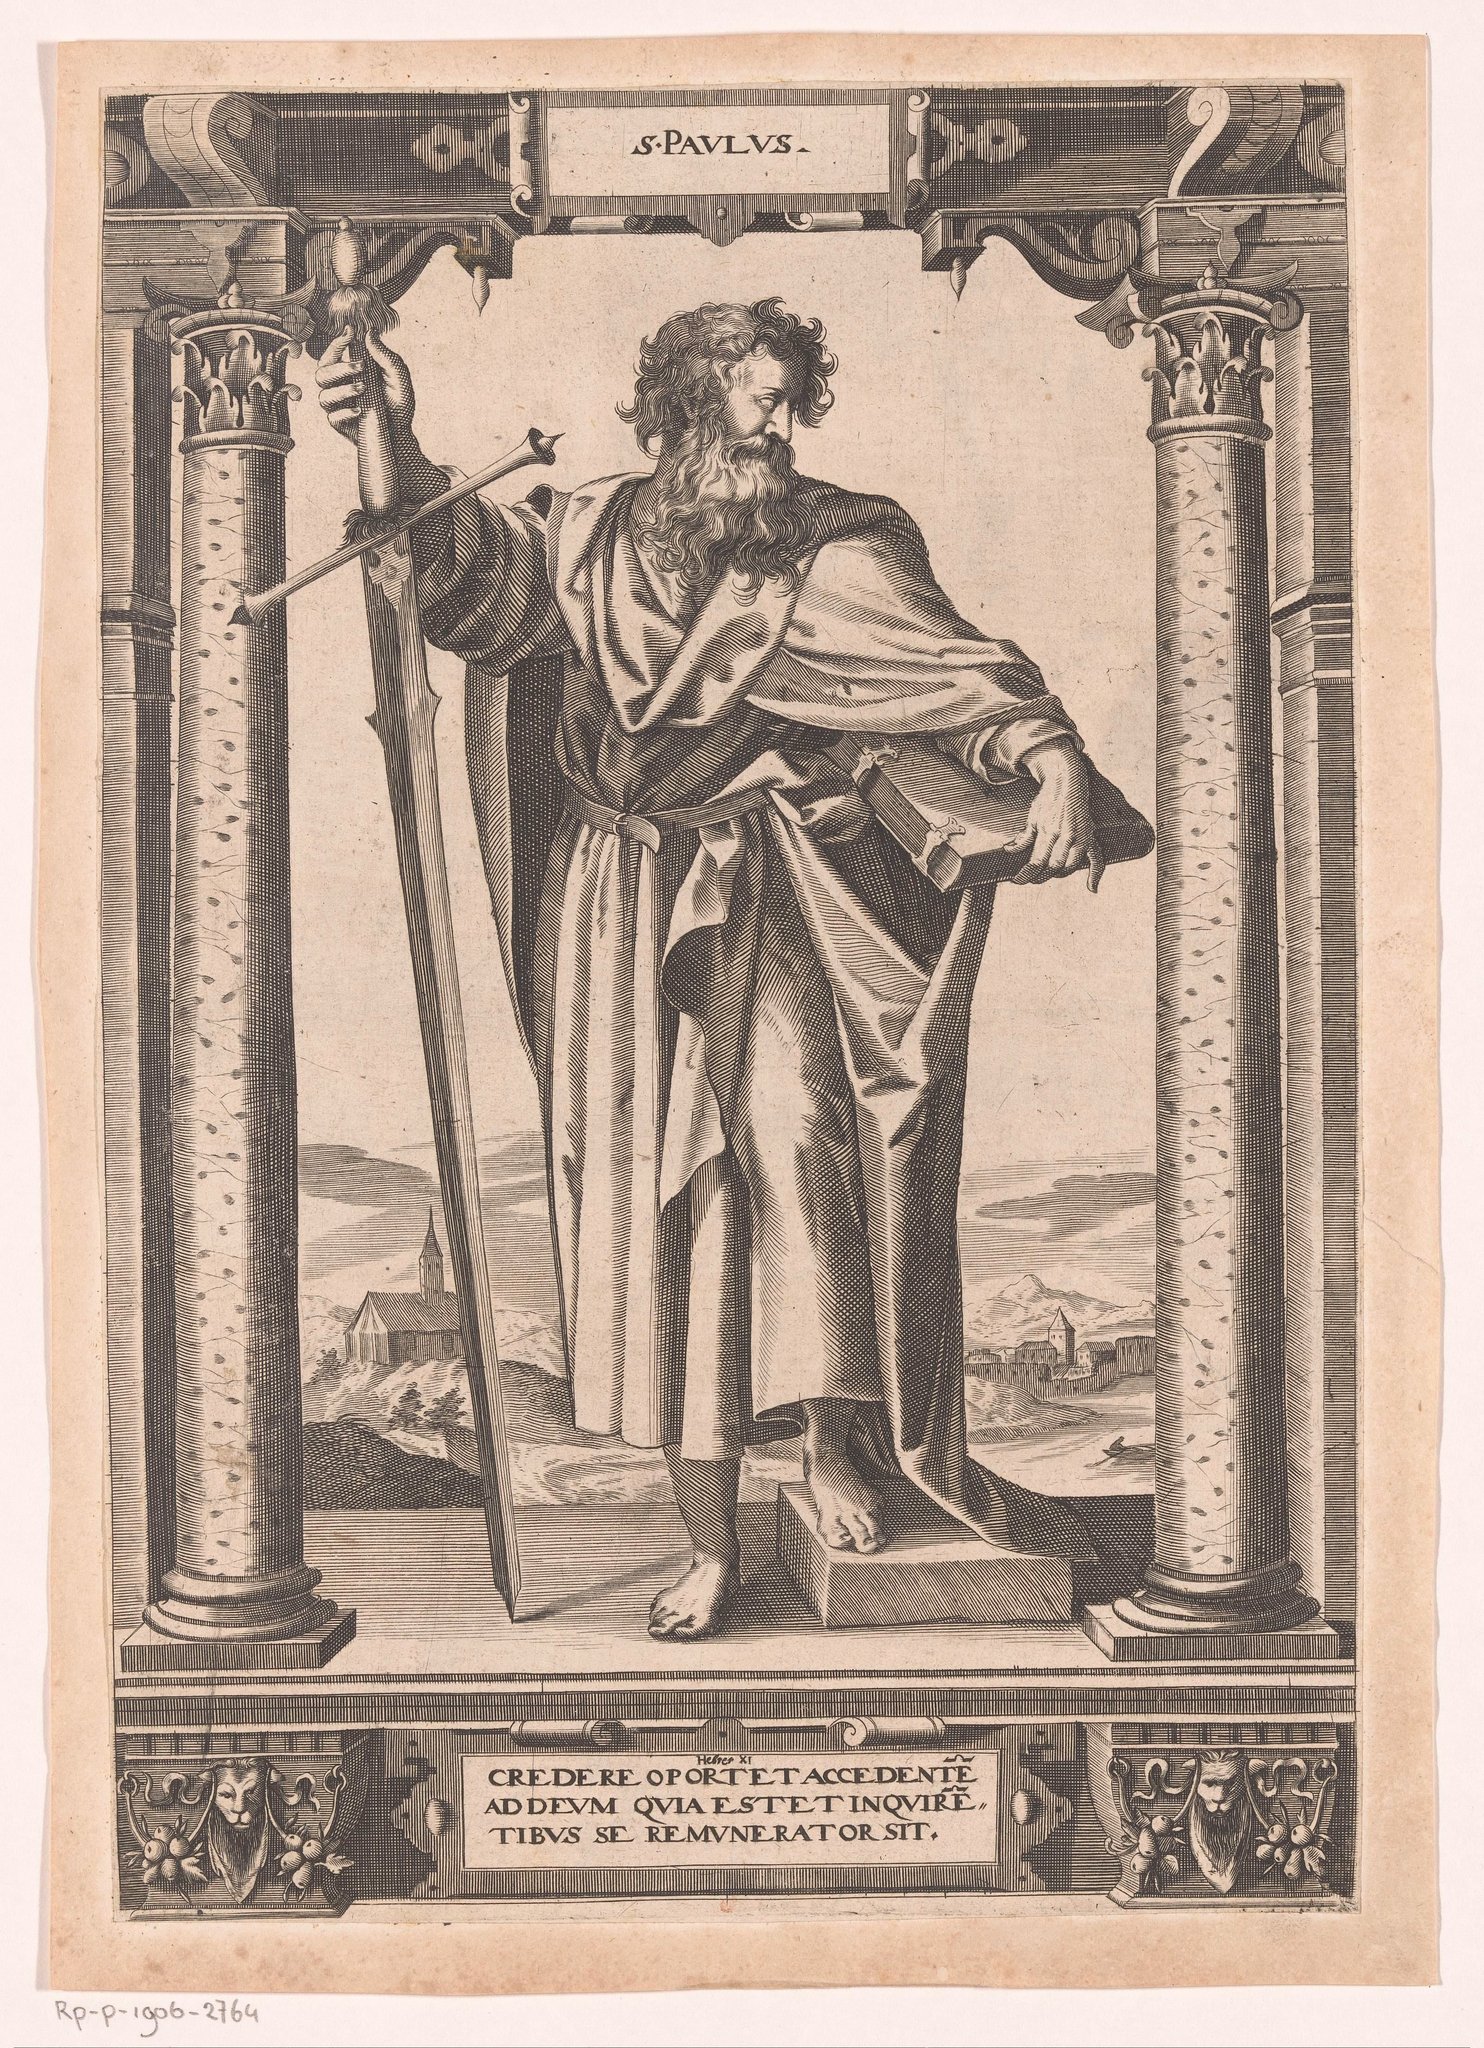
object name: print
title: Christus, de apostelen en H. Paulus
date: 1614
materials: paper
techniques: engraving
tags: architectural detail, the apostle paul of tarsus; possible attributes: book, scroll, sword - portrait of male saint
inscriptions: collector's mark: Lugt 2228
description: Onderdeel van een serie van veertien prenten. Vervaardigingsdetails vermeld op de eerste prent.